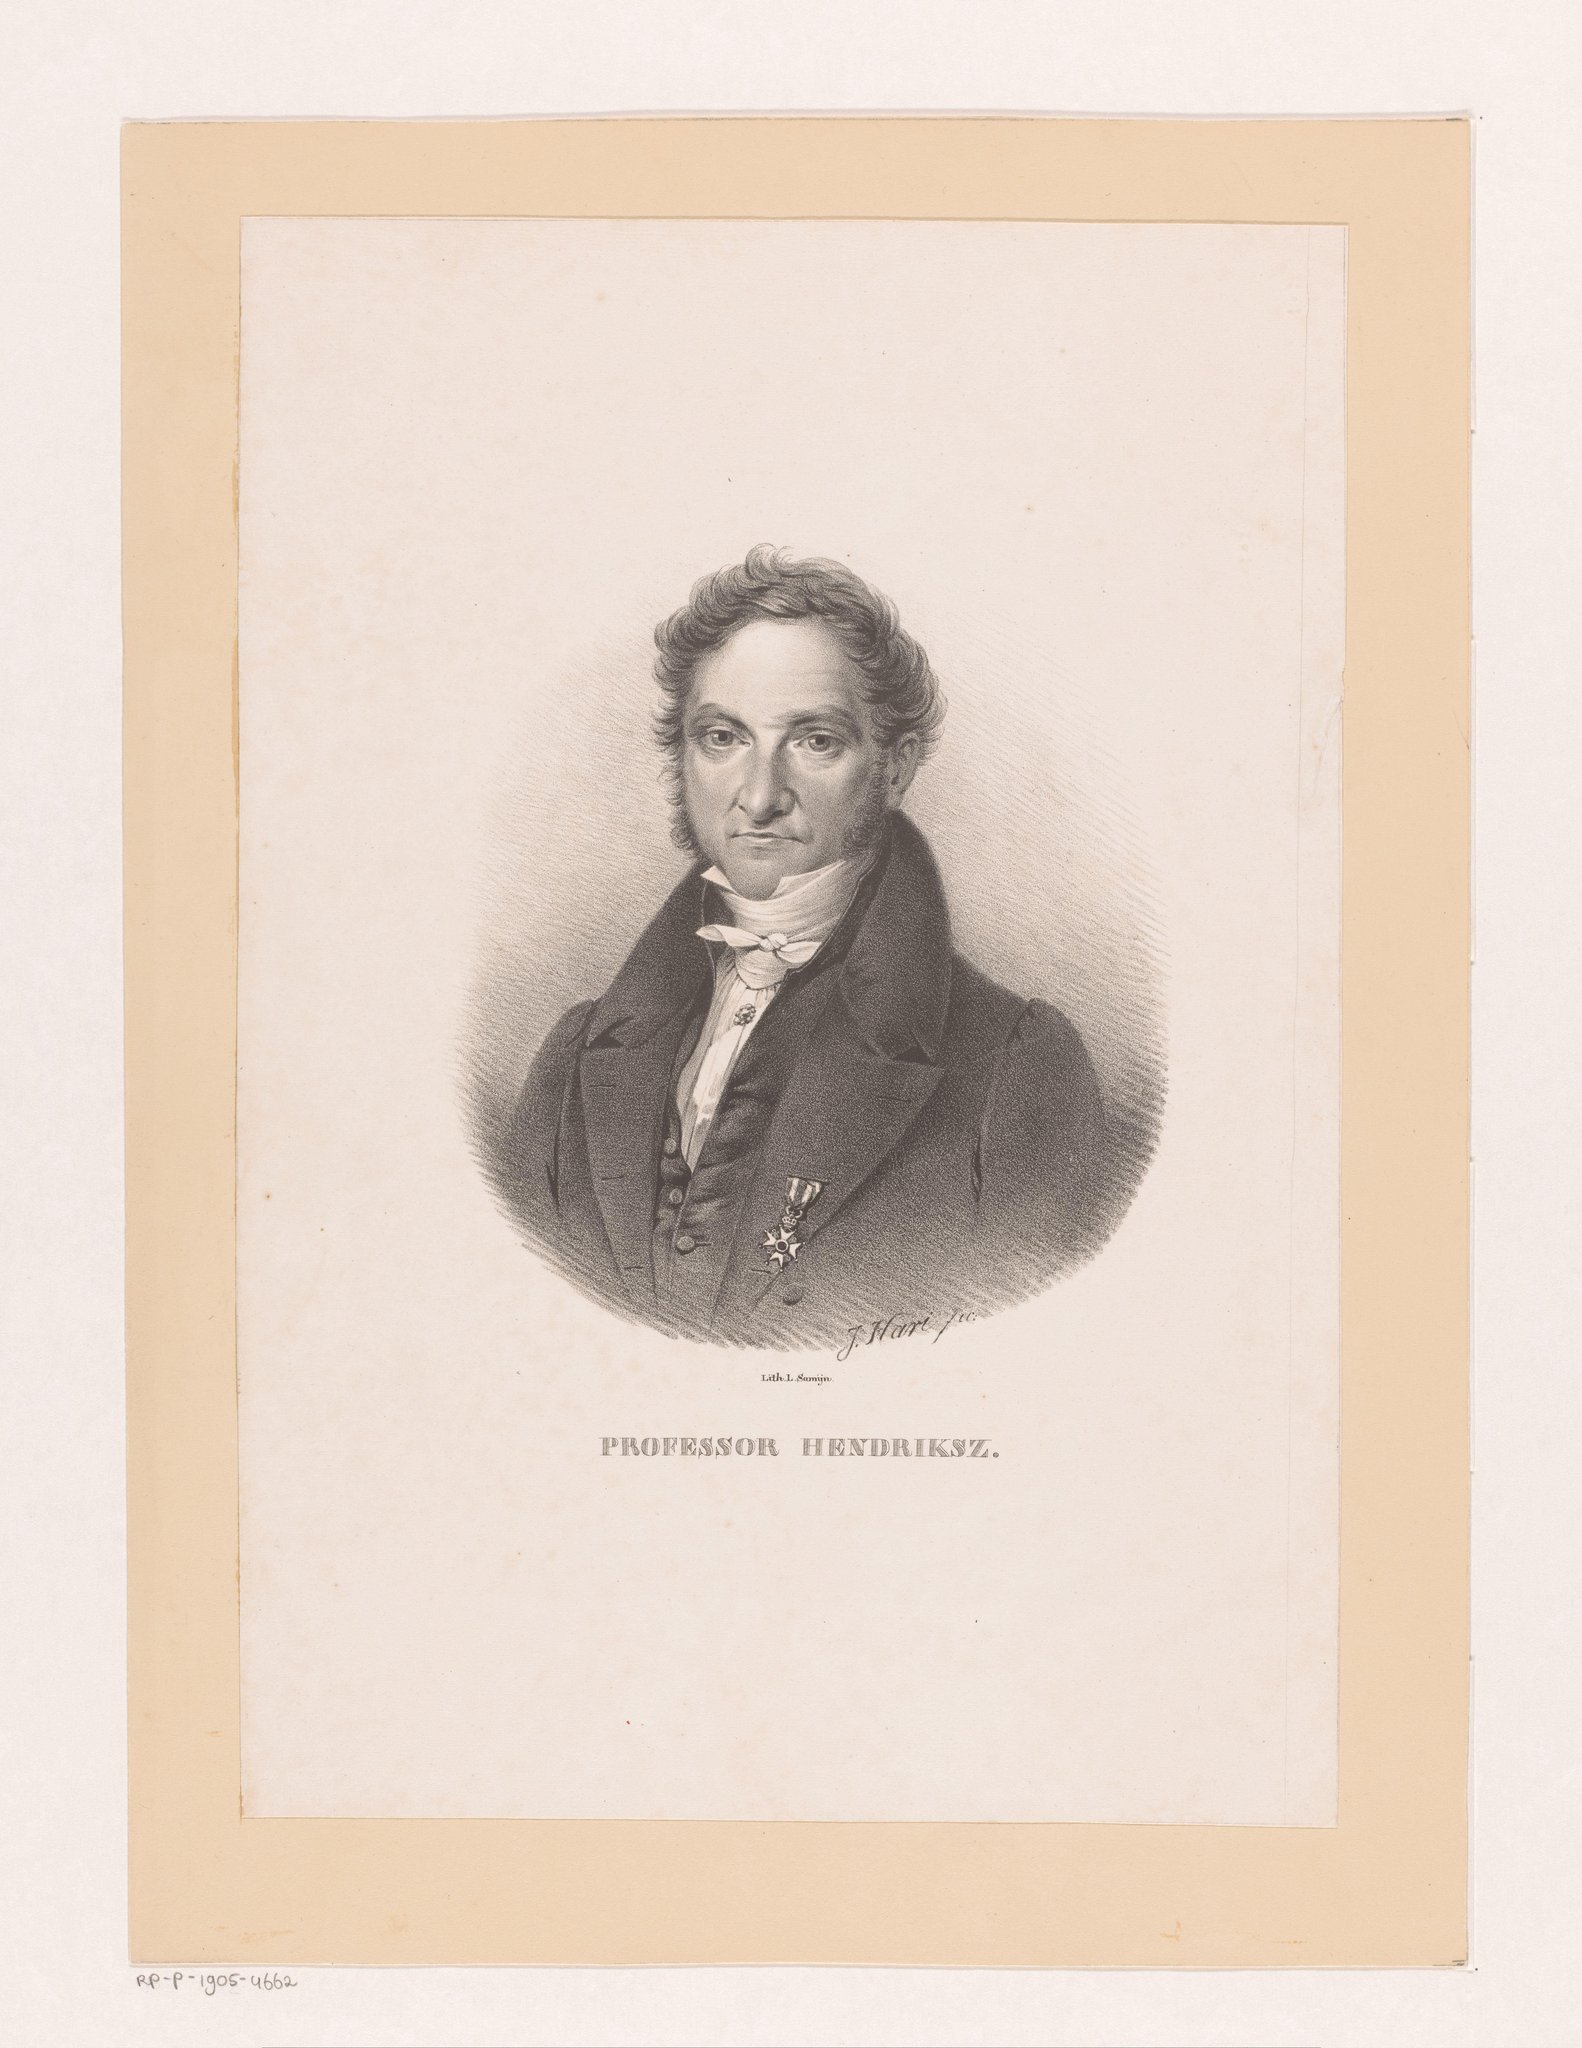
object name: print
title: Portret van professor Hendriksz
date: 1834-1835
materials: paper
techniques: lithograph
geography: amsterdam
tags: enkhuizen, knighthood order, historical persons (+ (full) bust portrait)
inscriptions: collector's mark: Lugt 2228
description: De geportretteerde draagt een ridderorde op zijn jas.